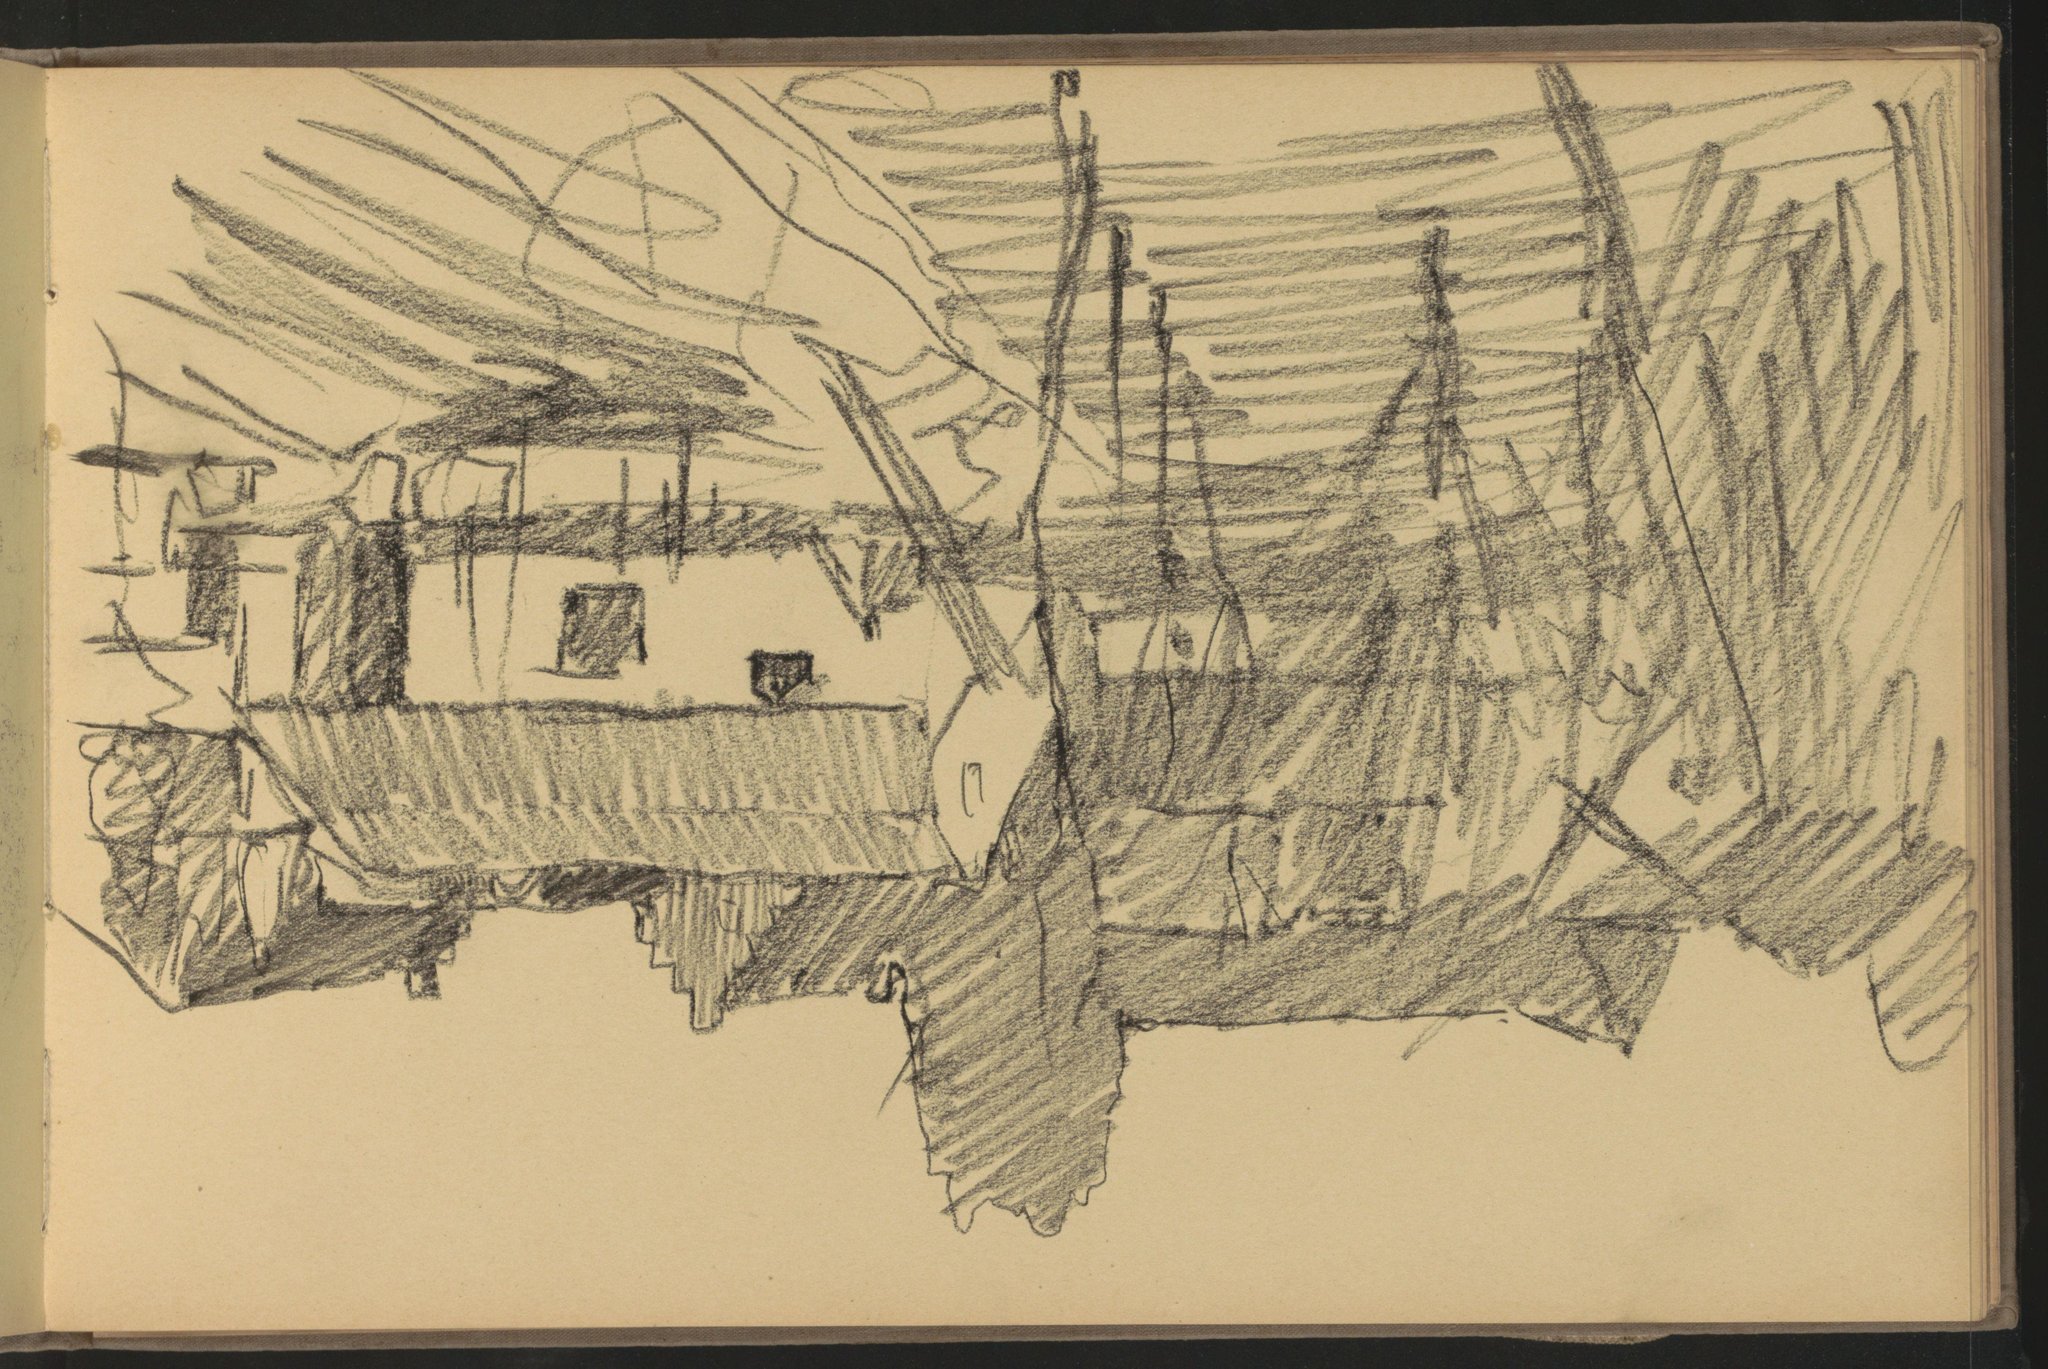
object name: sketchbook leaf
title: Gezicht op Wijk bij Duurstede met de Grote of Johannes de Doperkerk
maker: willem witsen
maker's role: draughtsman, painter, print maker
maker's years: 1860-1923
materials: chalk, paper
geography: wijk bij duurstede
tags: city-view, and landscape with man-made constructions, church (exterior)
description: Pagina 51 uit een schetsboek met 60 bladen.